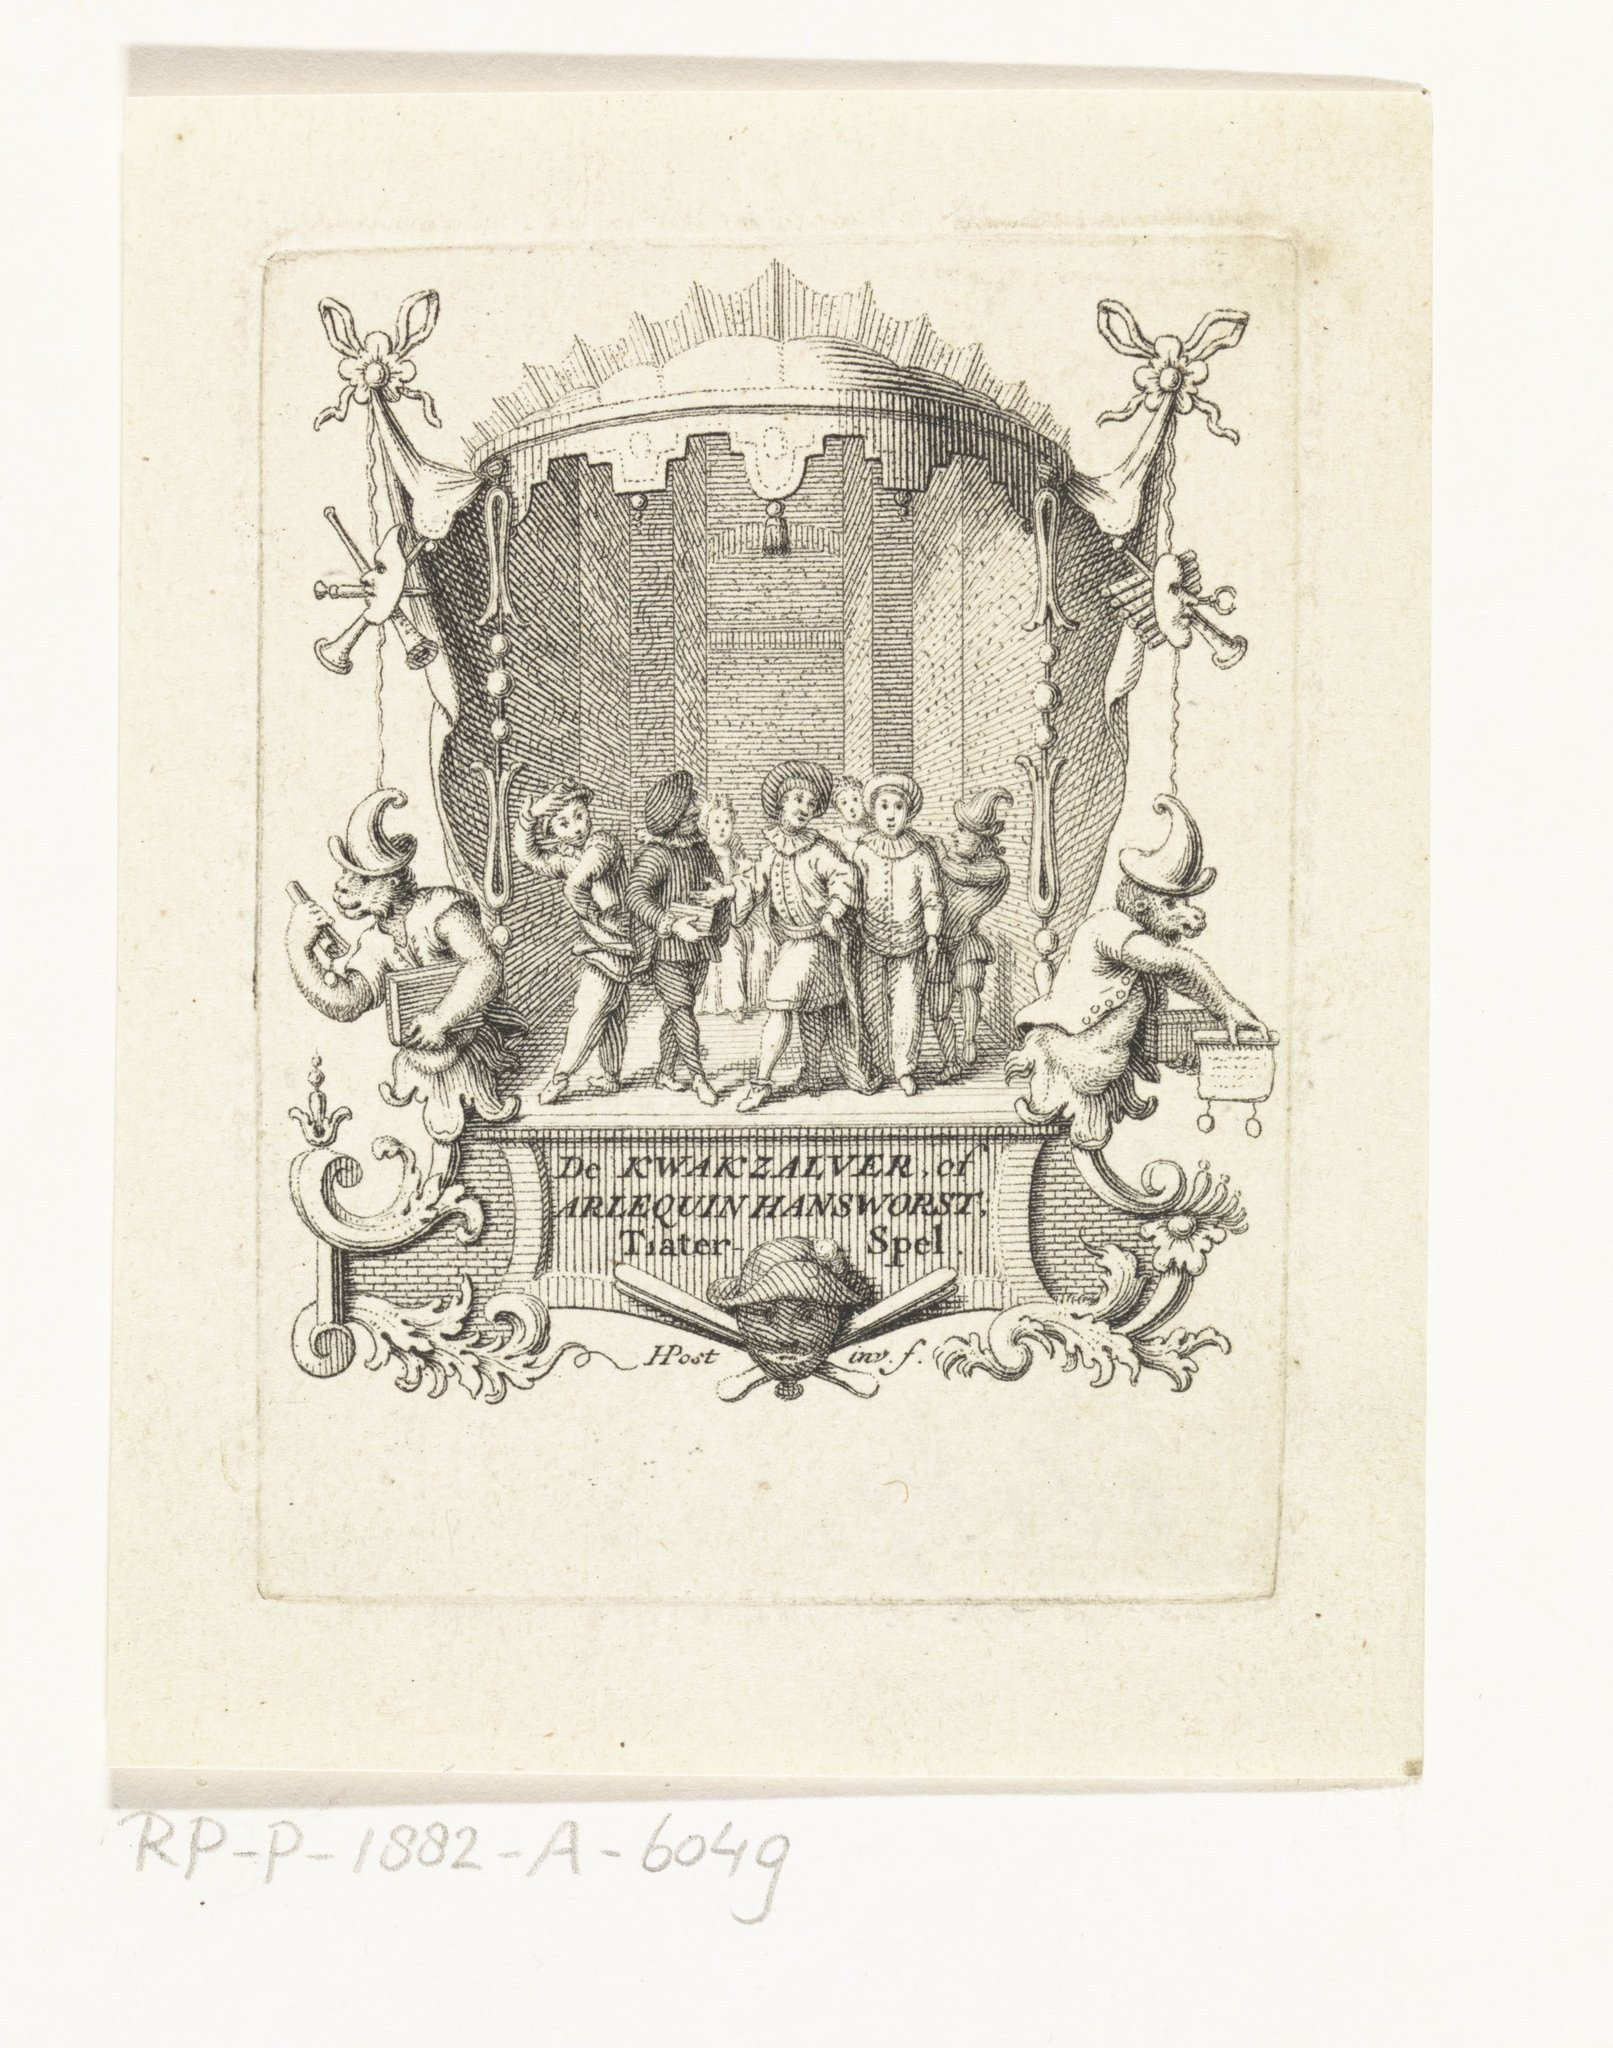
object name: print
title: De kwakzalver, of Arlequin Hansworst. Tiaterspel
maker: hendrik post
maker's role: draughtsman, print maker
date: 1718-1751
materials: paper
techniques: etching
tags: monkeys, apes, group of actors, troupe; actors on the stage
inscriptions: collector's mark: Lugt 2228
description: Vignet met een groep toneelspelers binnen een ornamentele omlijsting met muziekinstrumenten en maskers en twee aapjes met zotskappen, die boeken en documenten met zegels vasthouden. De titel van de klucht staat op een muur onder het toneel.